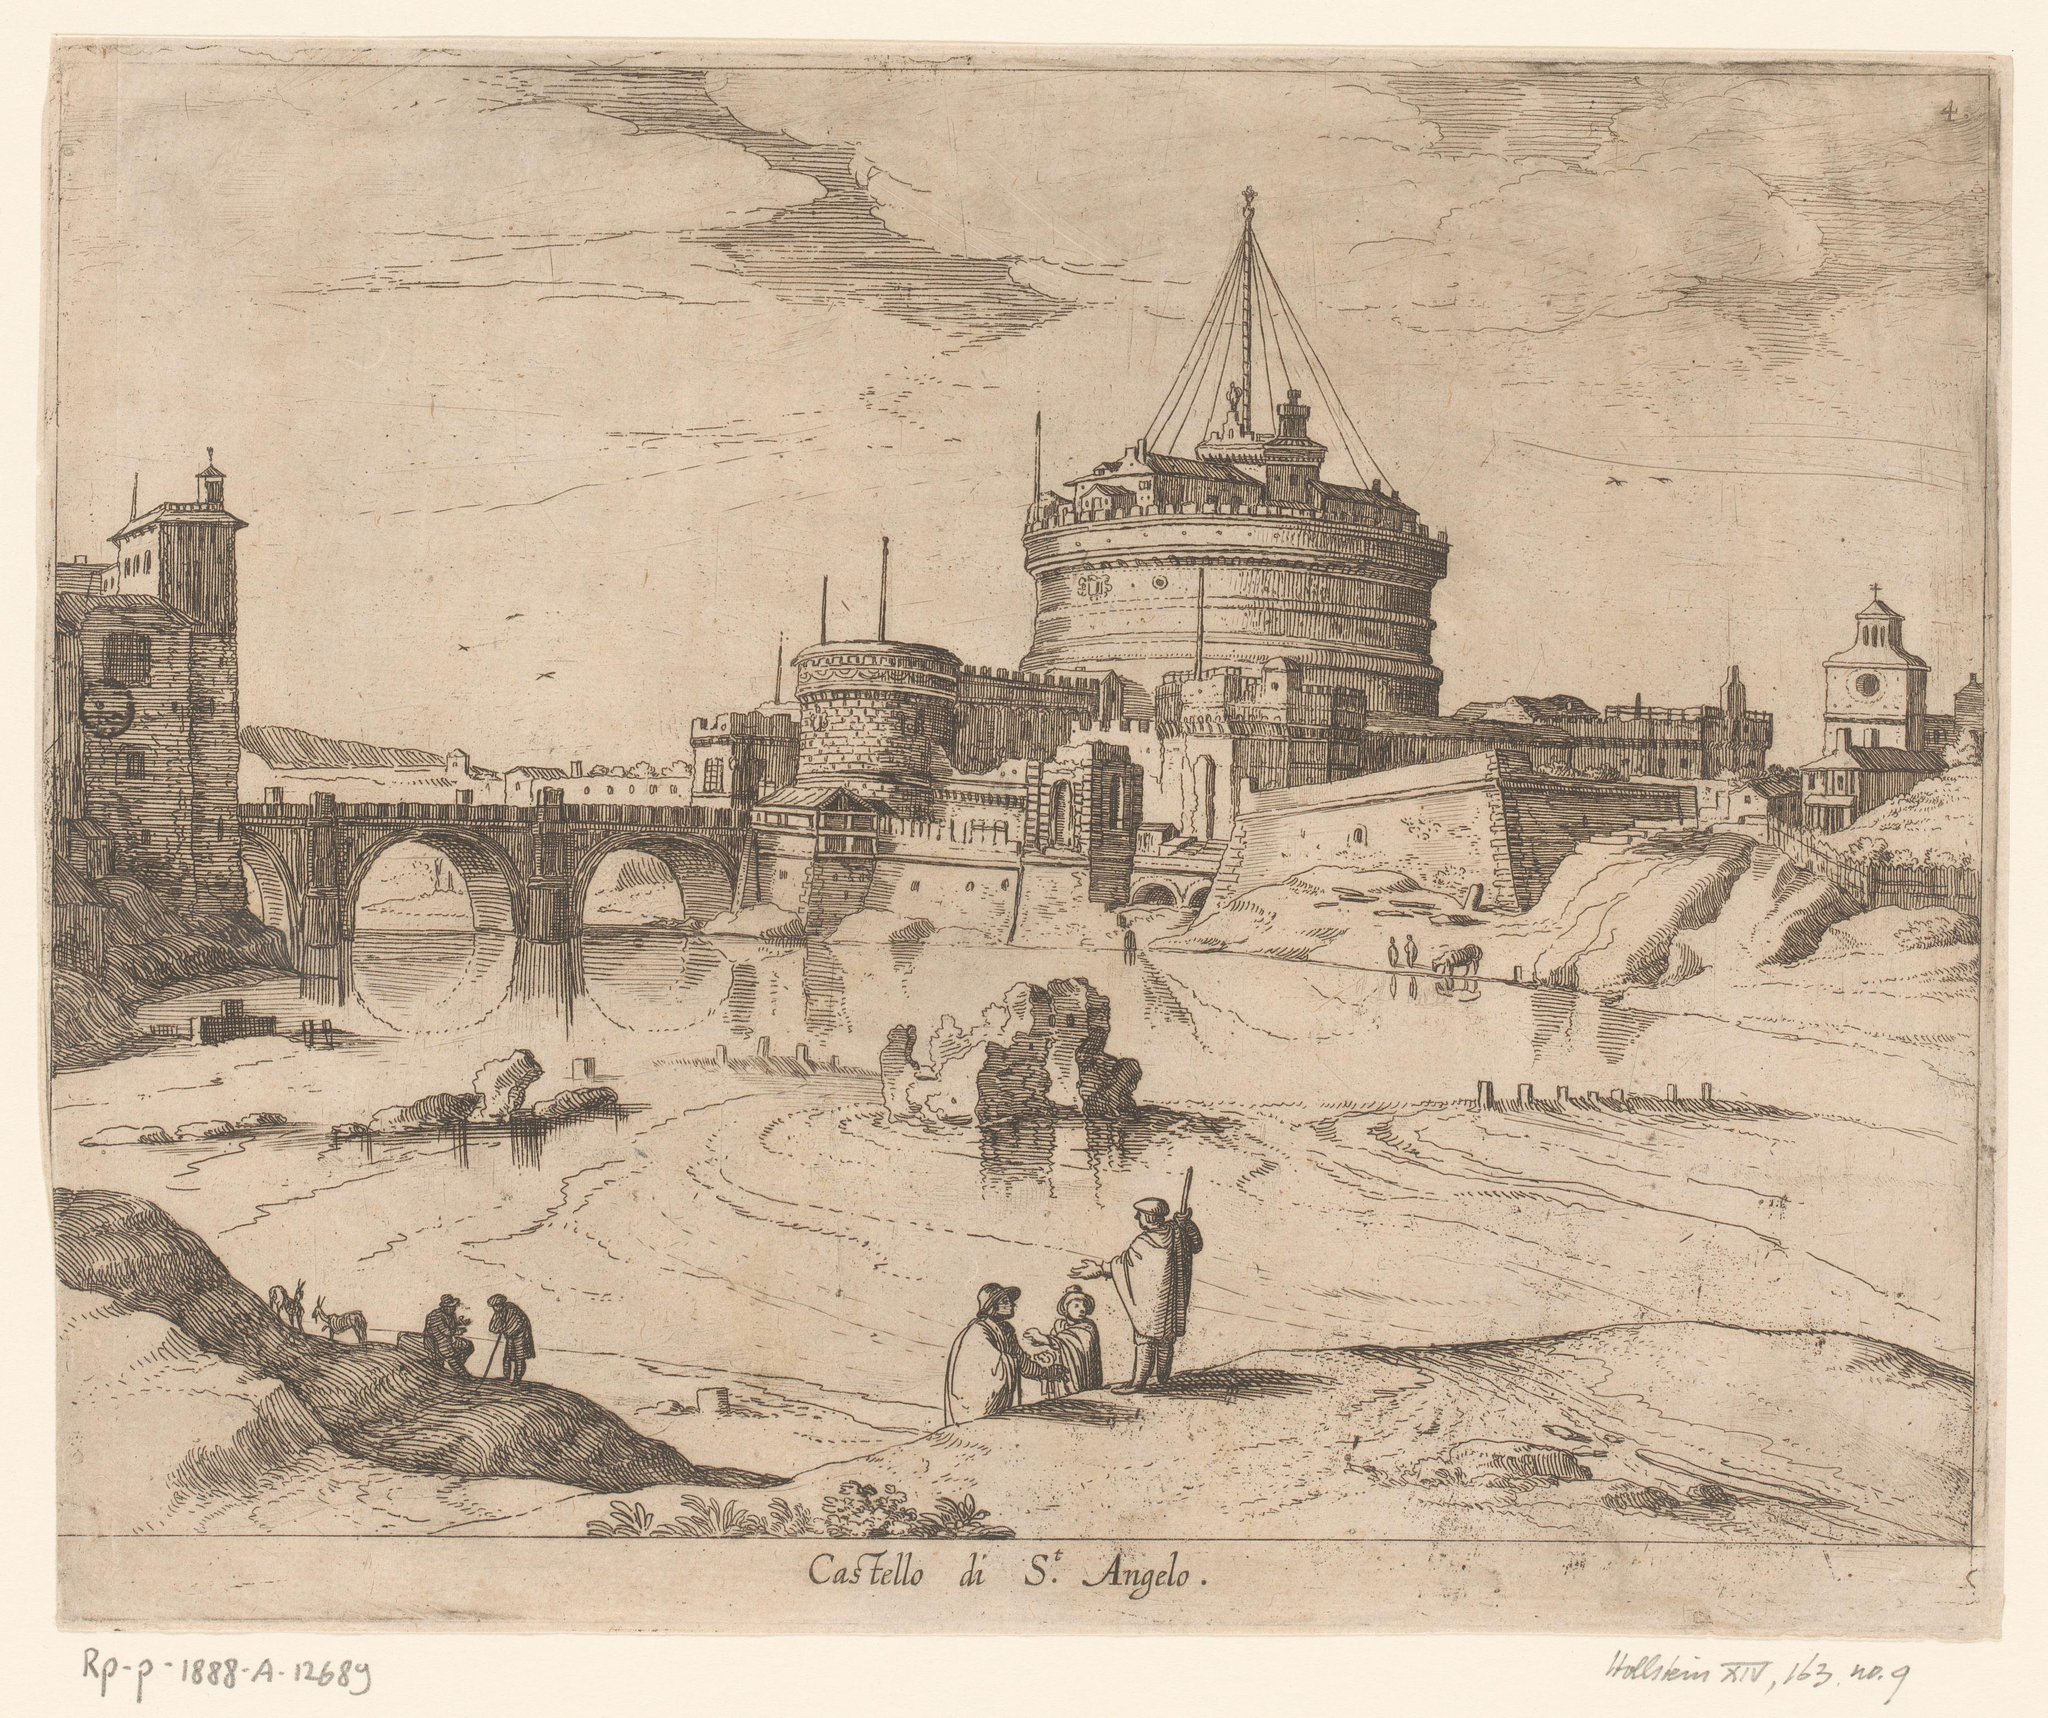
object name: print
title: Gezicht op de Engelenburcht, te Rome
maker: guilliam van nieulandt (ii)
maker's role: draughtsman, print maker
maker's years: 1584-1635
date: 1594-1635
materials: paper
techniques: etching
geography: antwerp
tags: castle, rome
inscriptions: collector's mark: Lugt 2228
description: De Engelenburcht aan de Tiber in Rome, met links de Engelenbrug. Op de voorgrond op de oever zijn drie figuren met elkaar in gesprek.